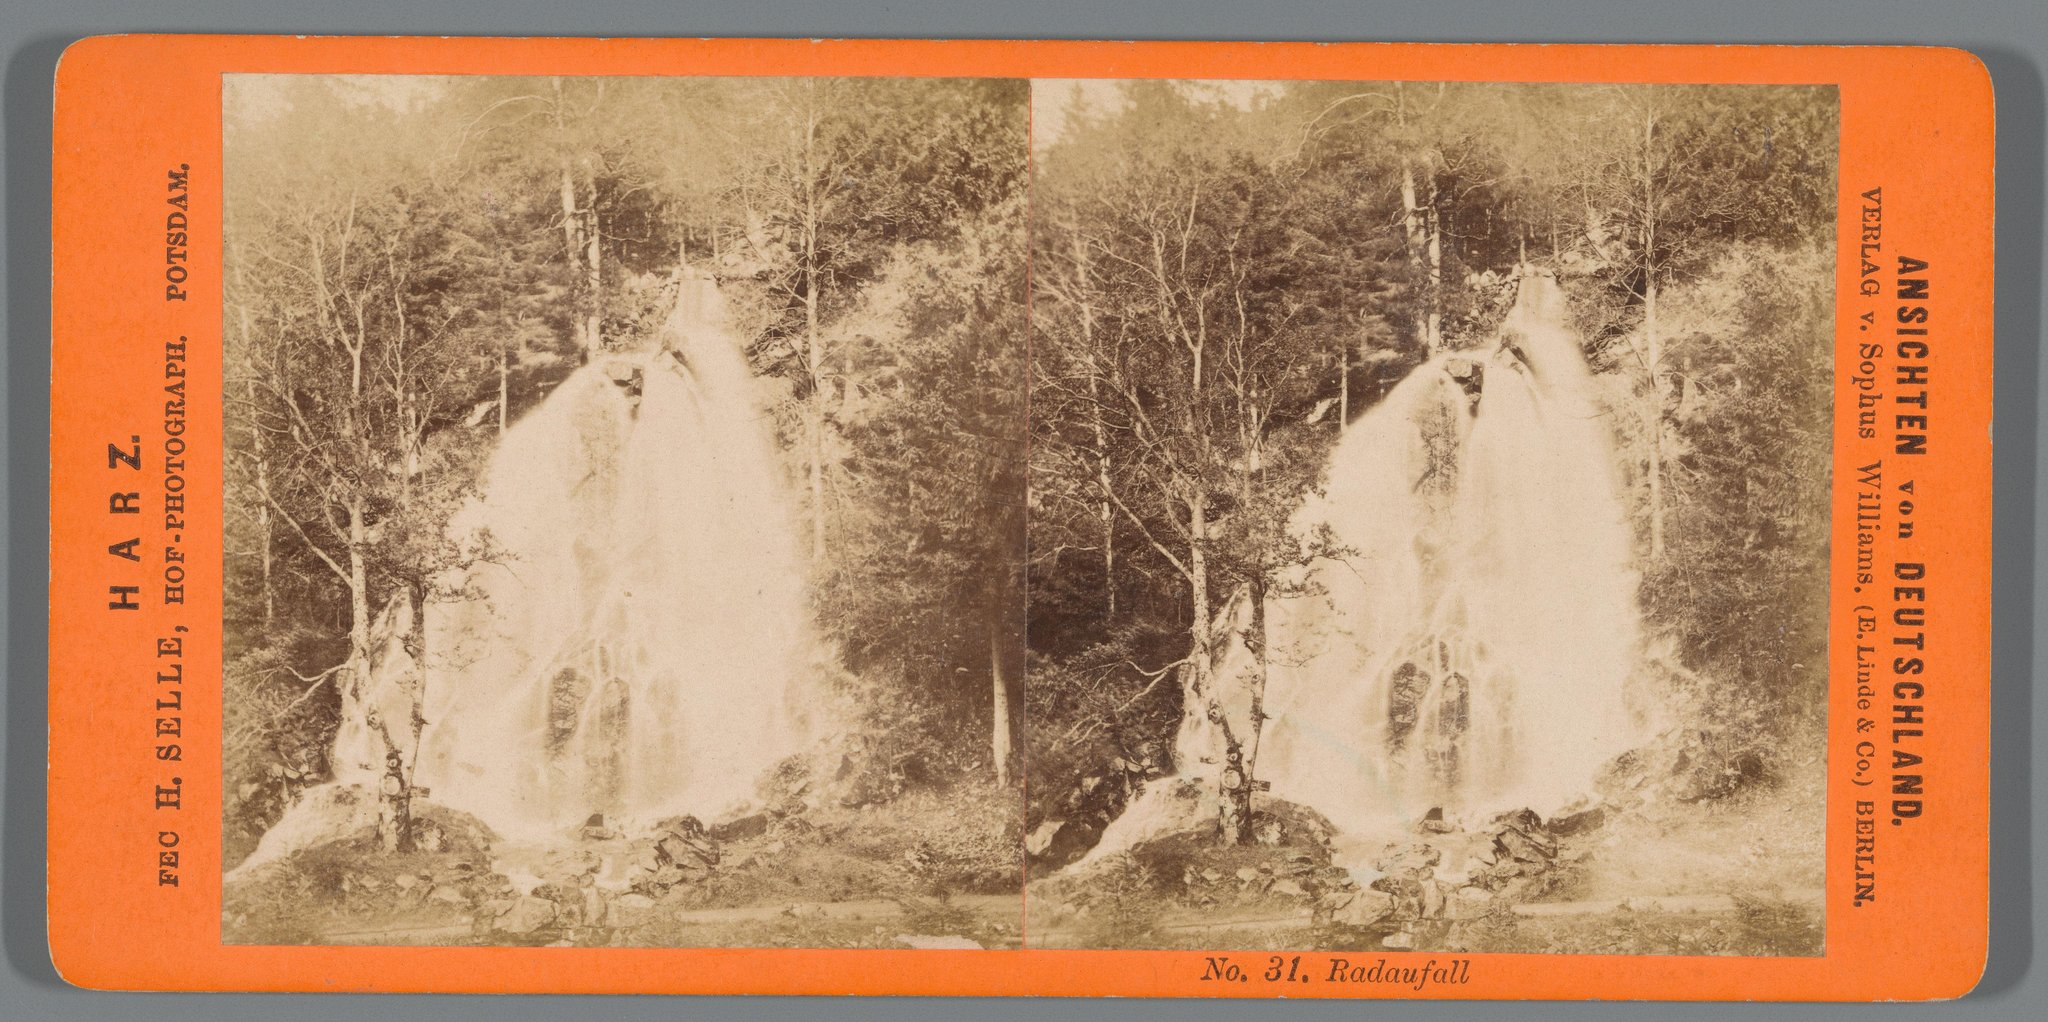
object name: stereograph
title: Radaufall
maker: hermann selle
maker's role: fotograaf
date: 1868-1880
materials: cardboard, paper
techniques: albumen print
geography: harz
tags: waterfall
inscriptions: number: ‘No. 31.’